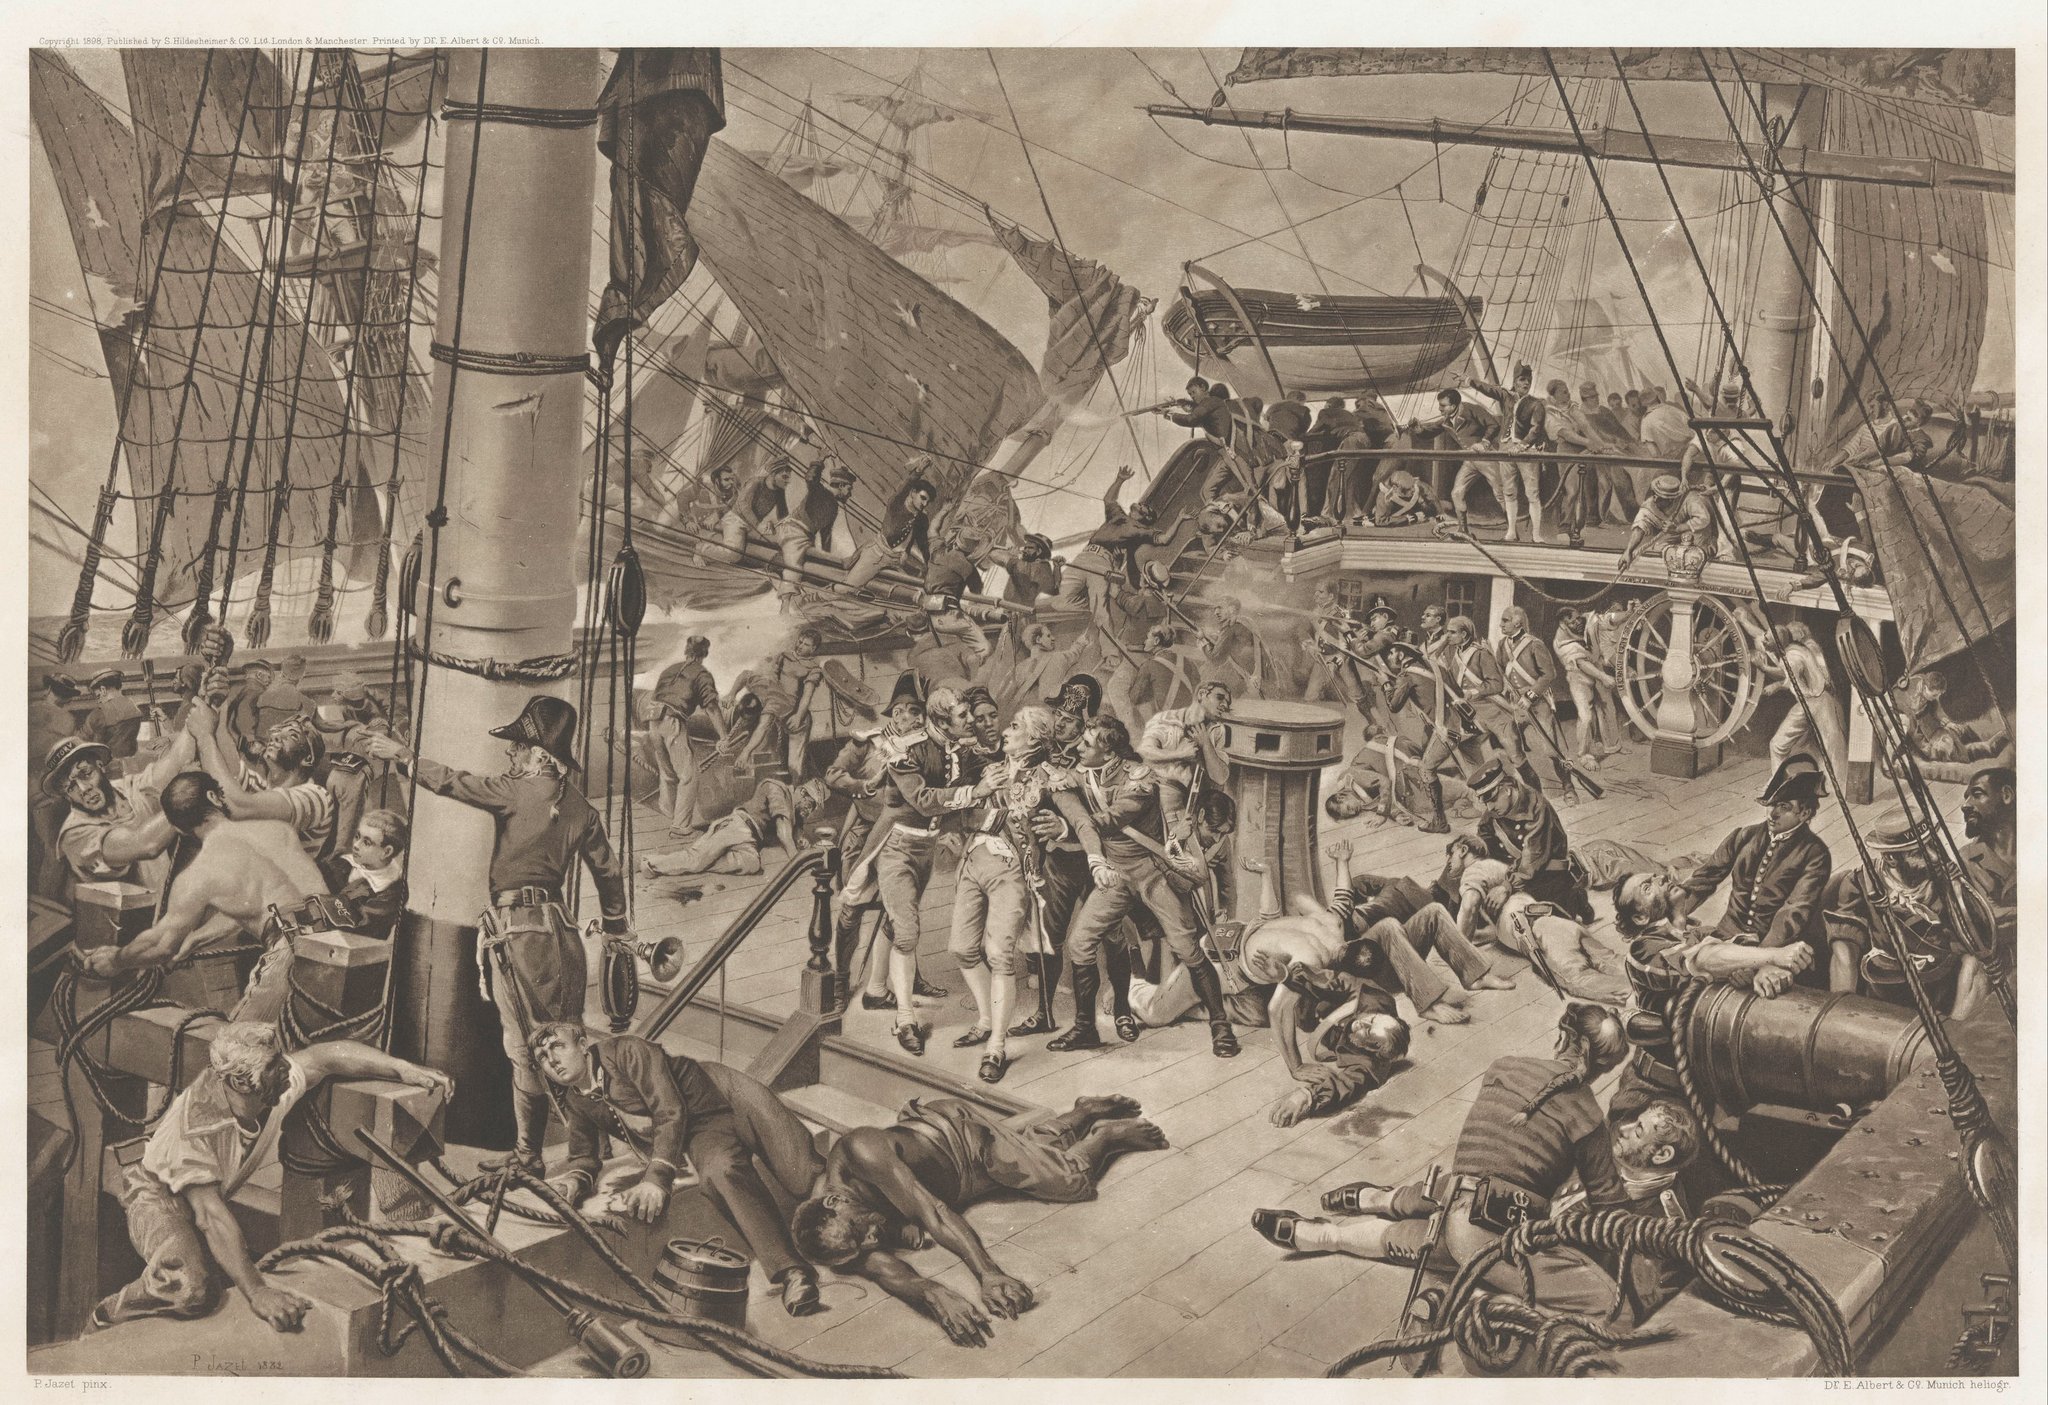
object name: photomechanical print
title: Battle of Trafalgar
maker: paul léon jazet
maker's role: painter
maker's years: 1848-1918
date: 1898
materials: paper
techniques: photoaquatint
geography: munich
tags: horatio nelson (hertog van bronte), dying, battle (+ sailing-ships)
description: Dood van admiraal Horatio Nelson tijdens de zeeslag bij Trafalgar, 21 oktober 1805.